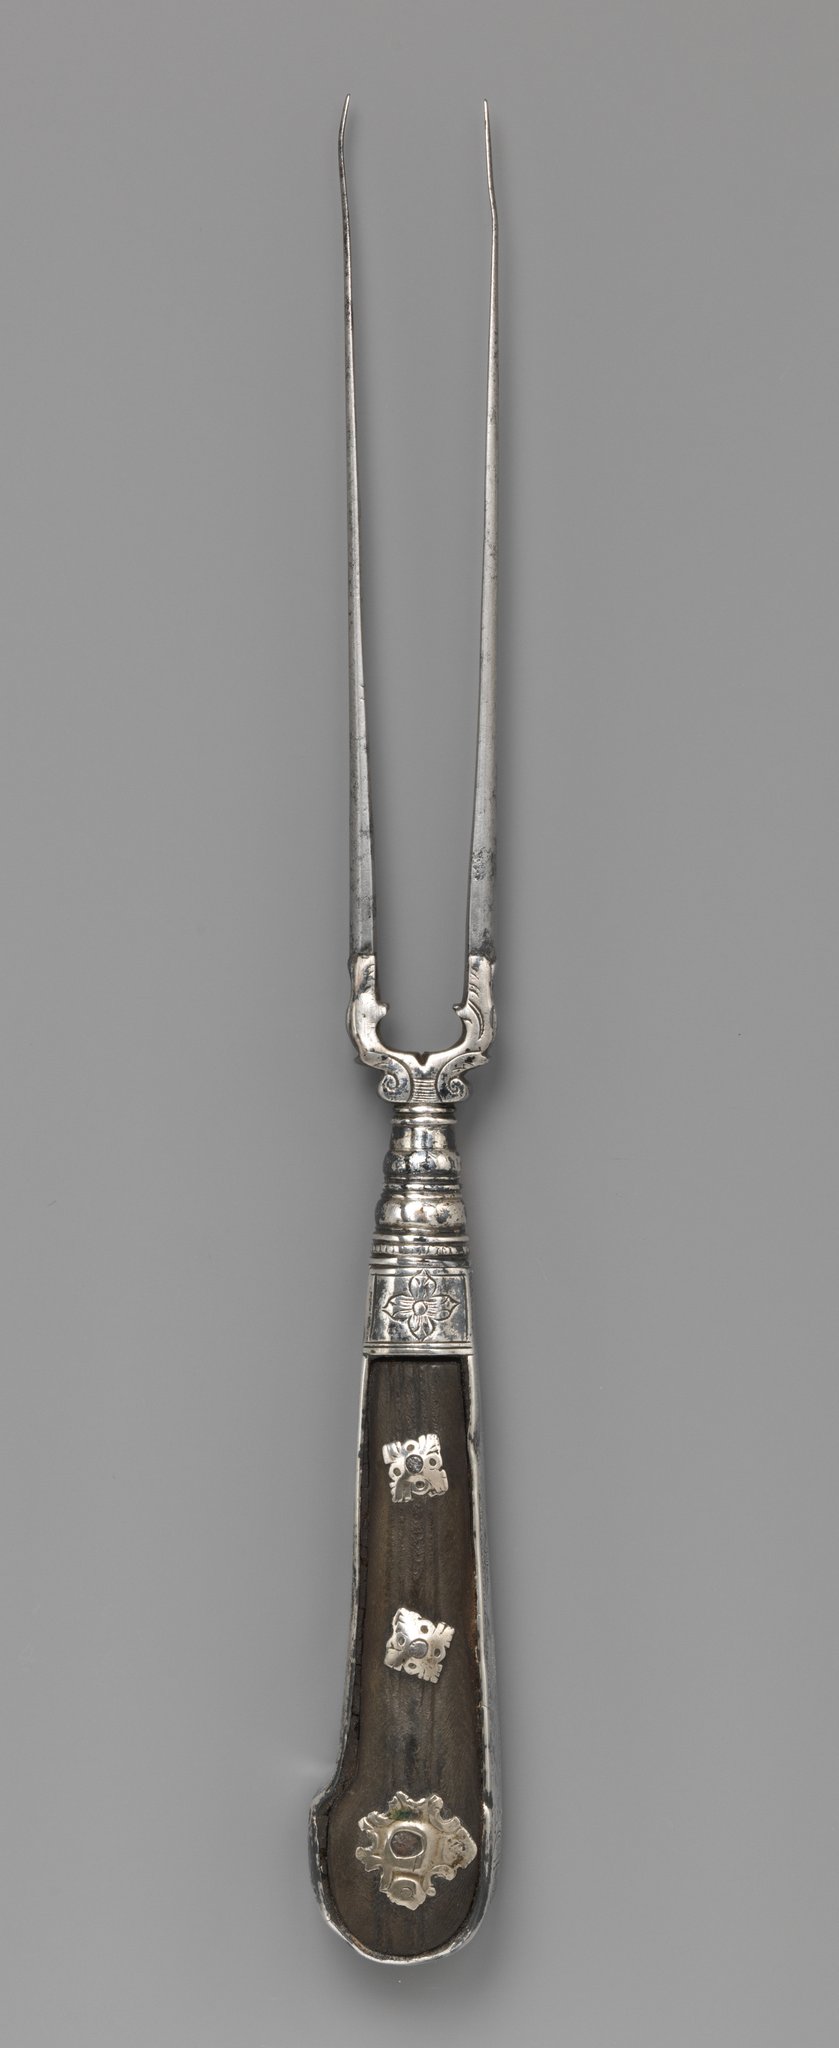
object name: table fork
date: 1701-1800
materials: silver, steel, wood